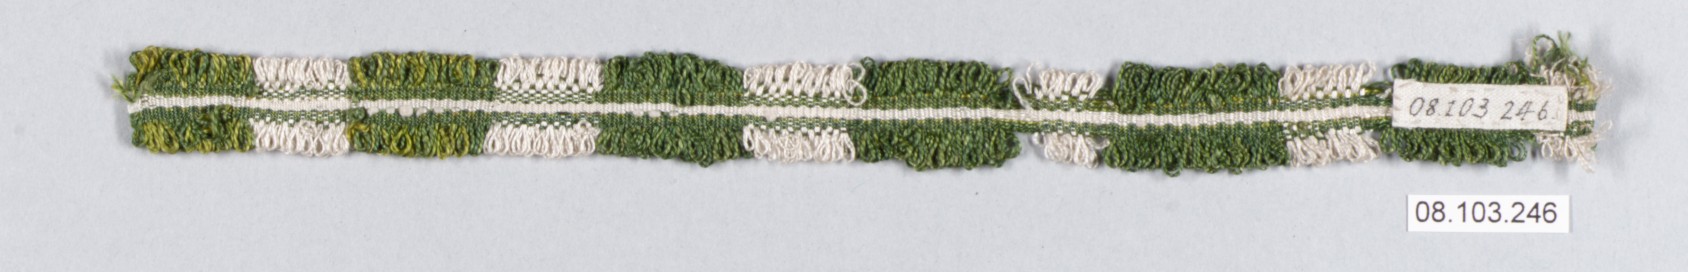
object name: gimp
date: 1701-1800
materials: silk